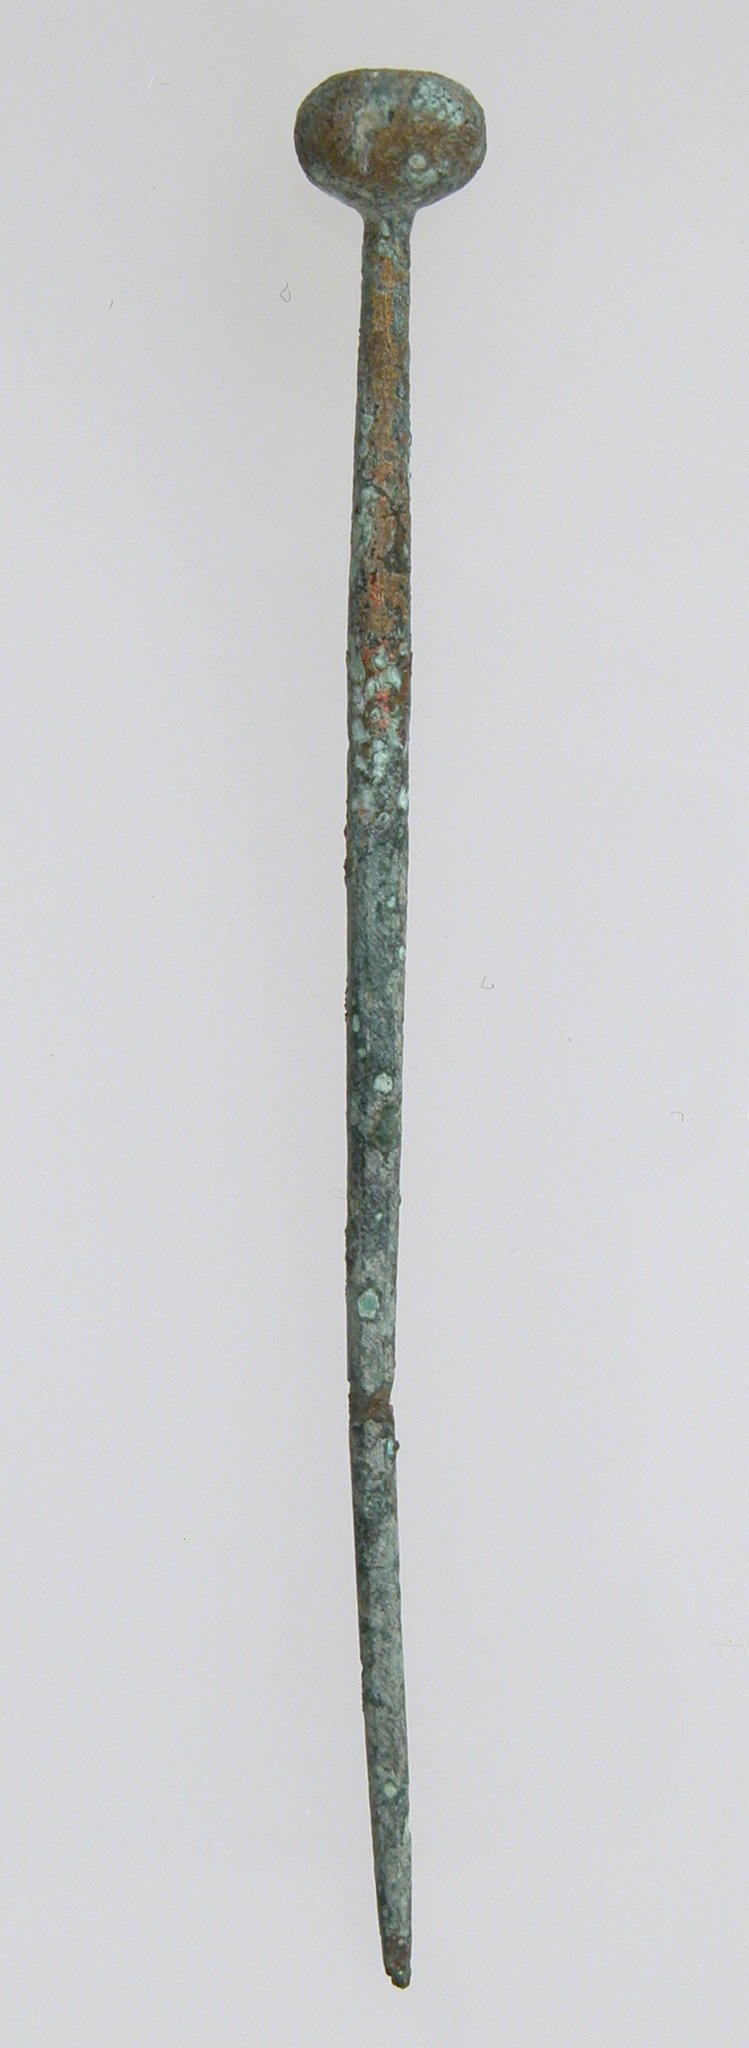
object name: hairpin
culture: roman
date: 200-500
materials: copper alloy